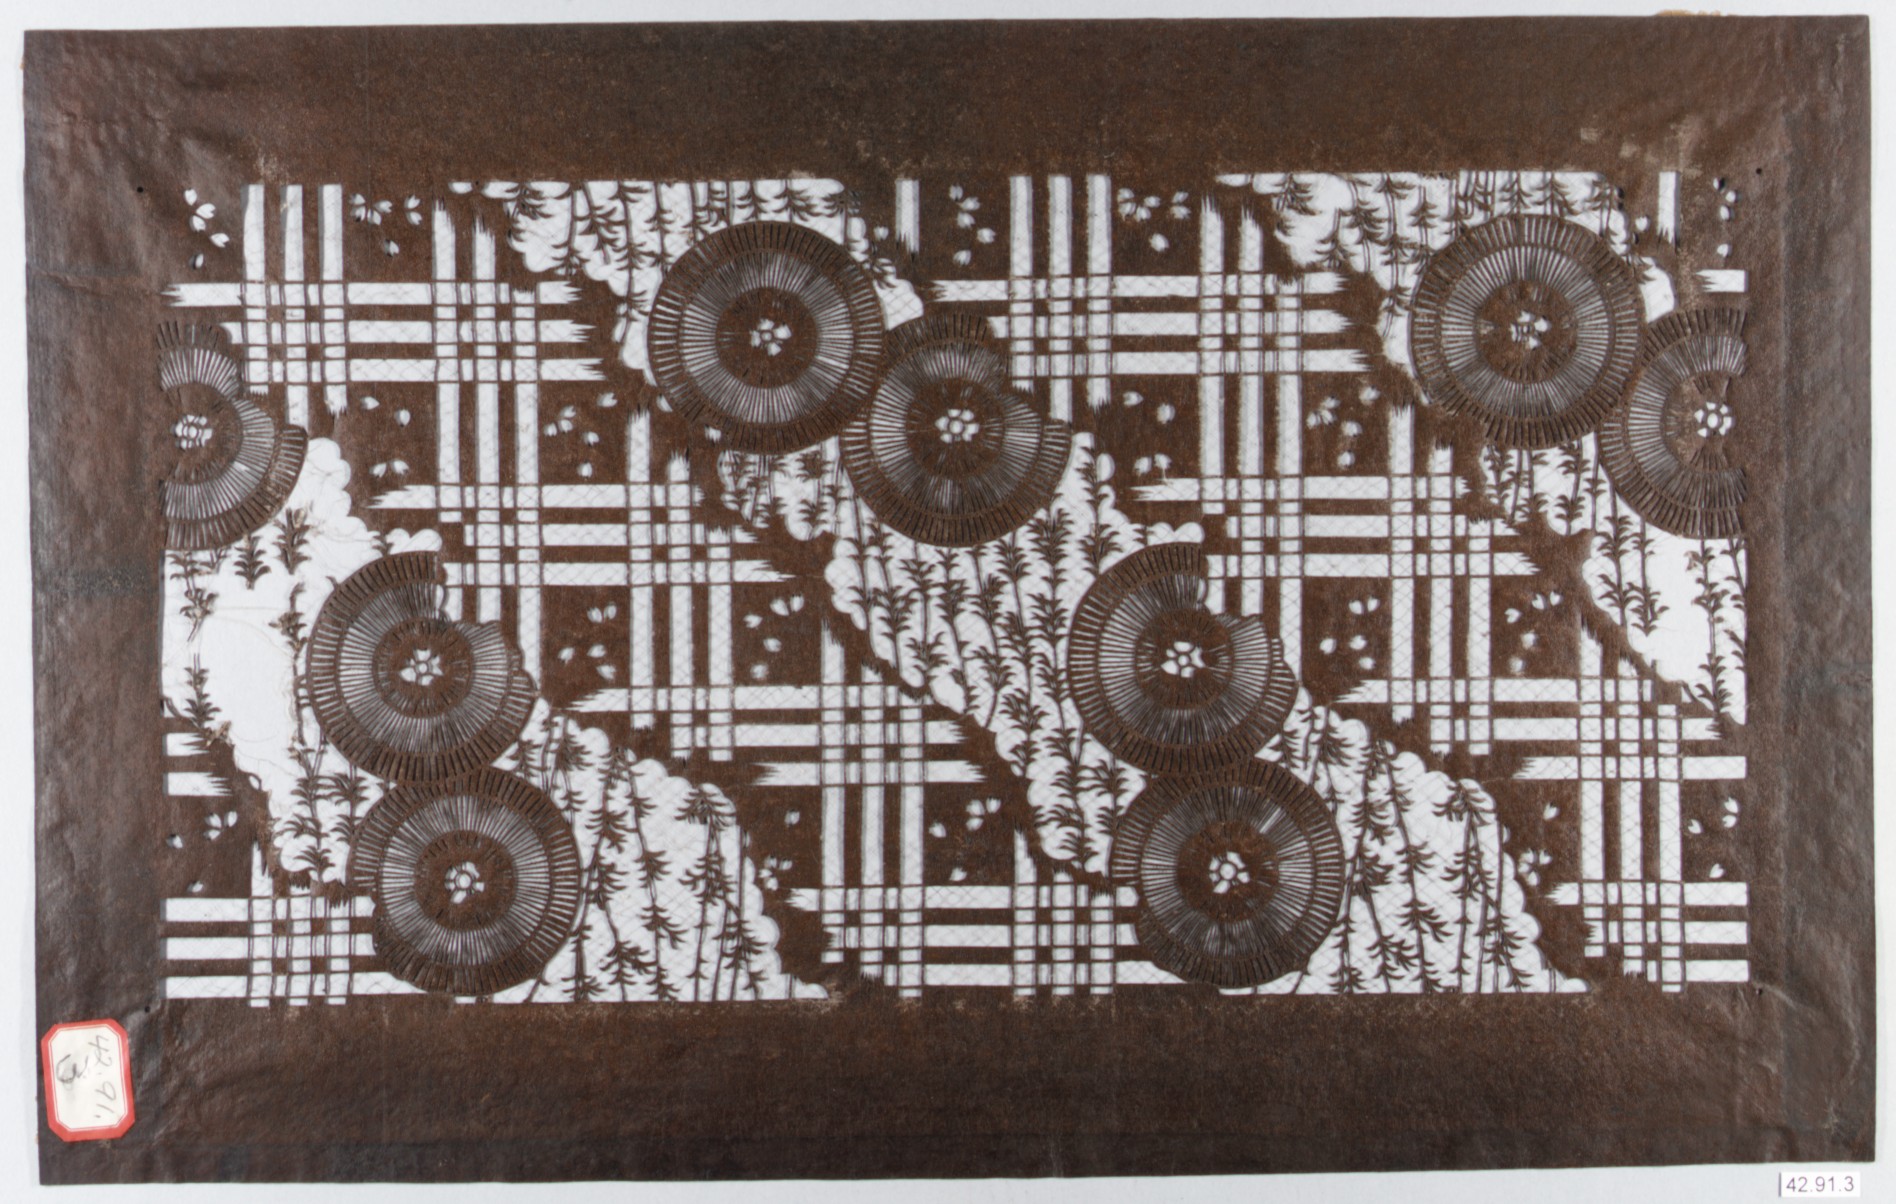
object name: stencil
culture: japanese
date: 1801-1900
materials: paper, silk